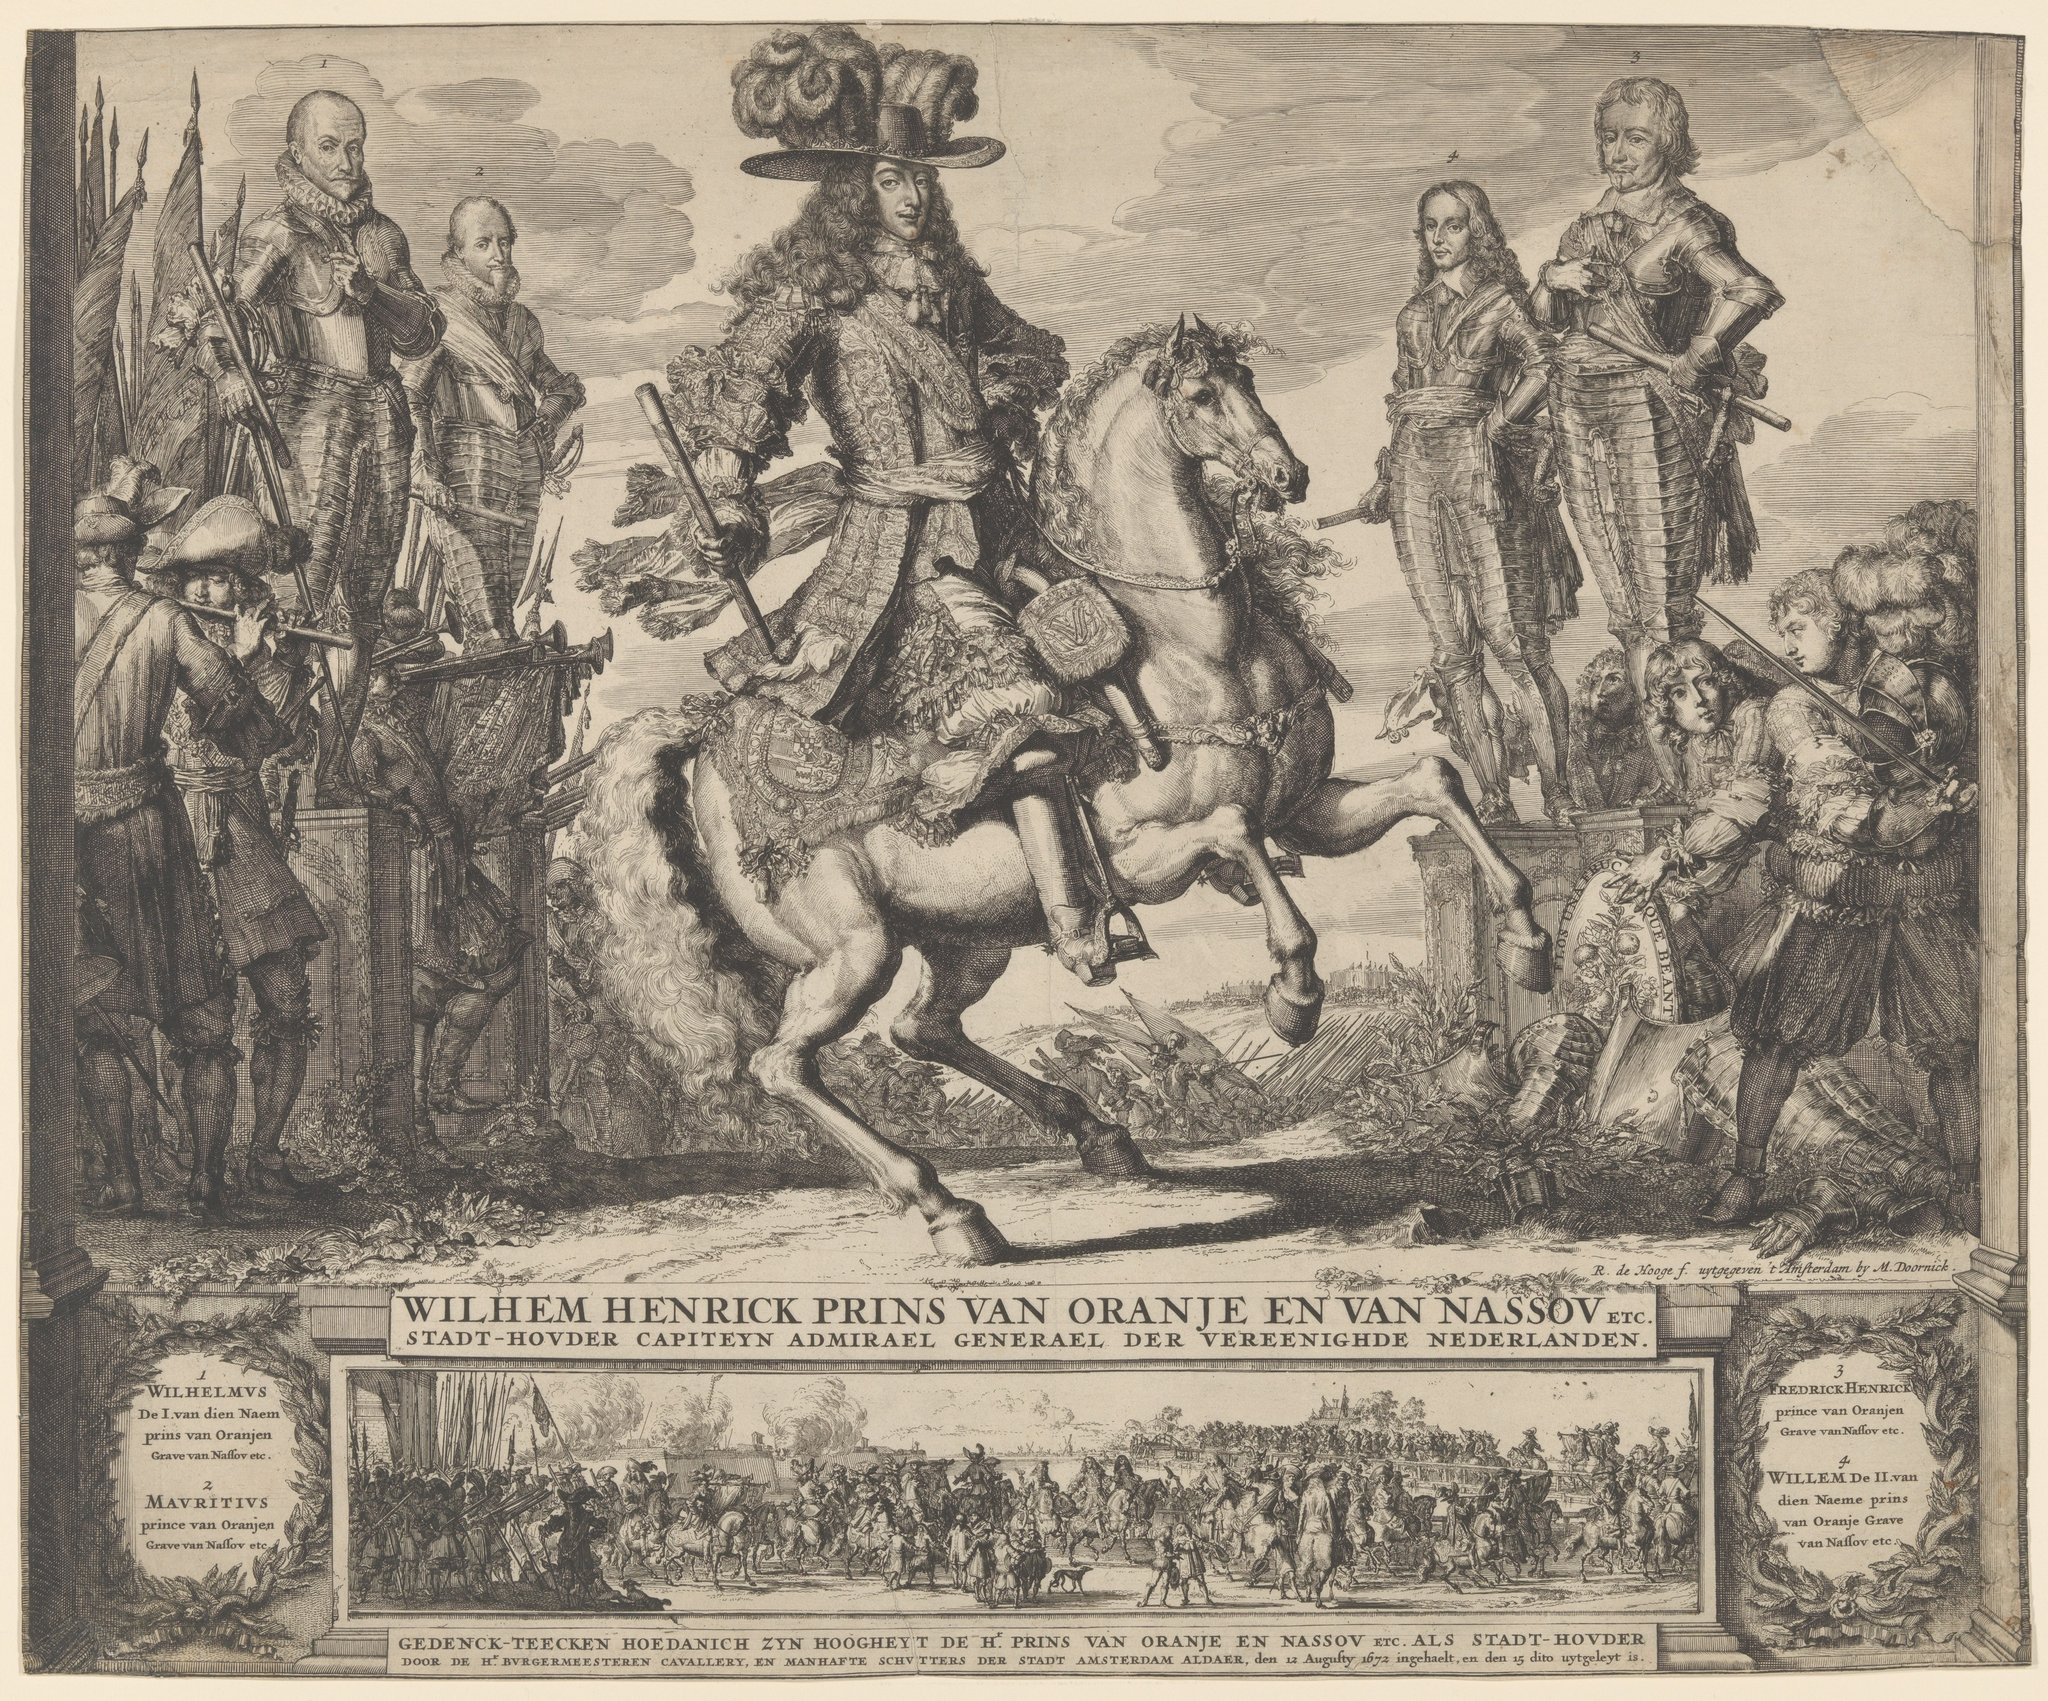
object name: print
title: William III as Prince of Orange, with the four preceding Stadthouders, William I, Maurice, Frederick Hendrick, William II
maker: romeyn de hooghe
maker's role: artist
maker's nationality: dutch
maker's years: 1645-1708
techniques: etching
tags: princes,men,horses